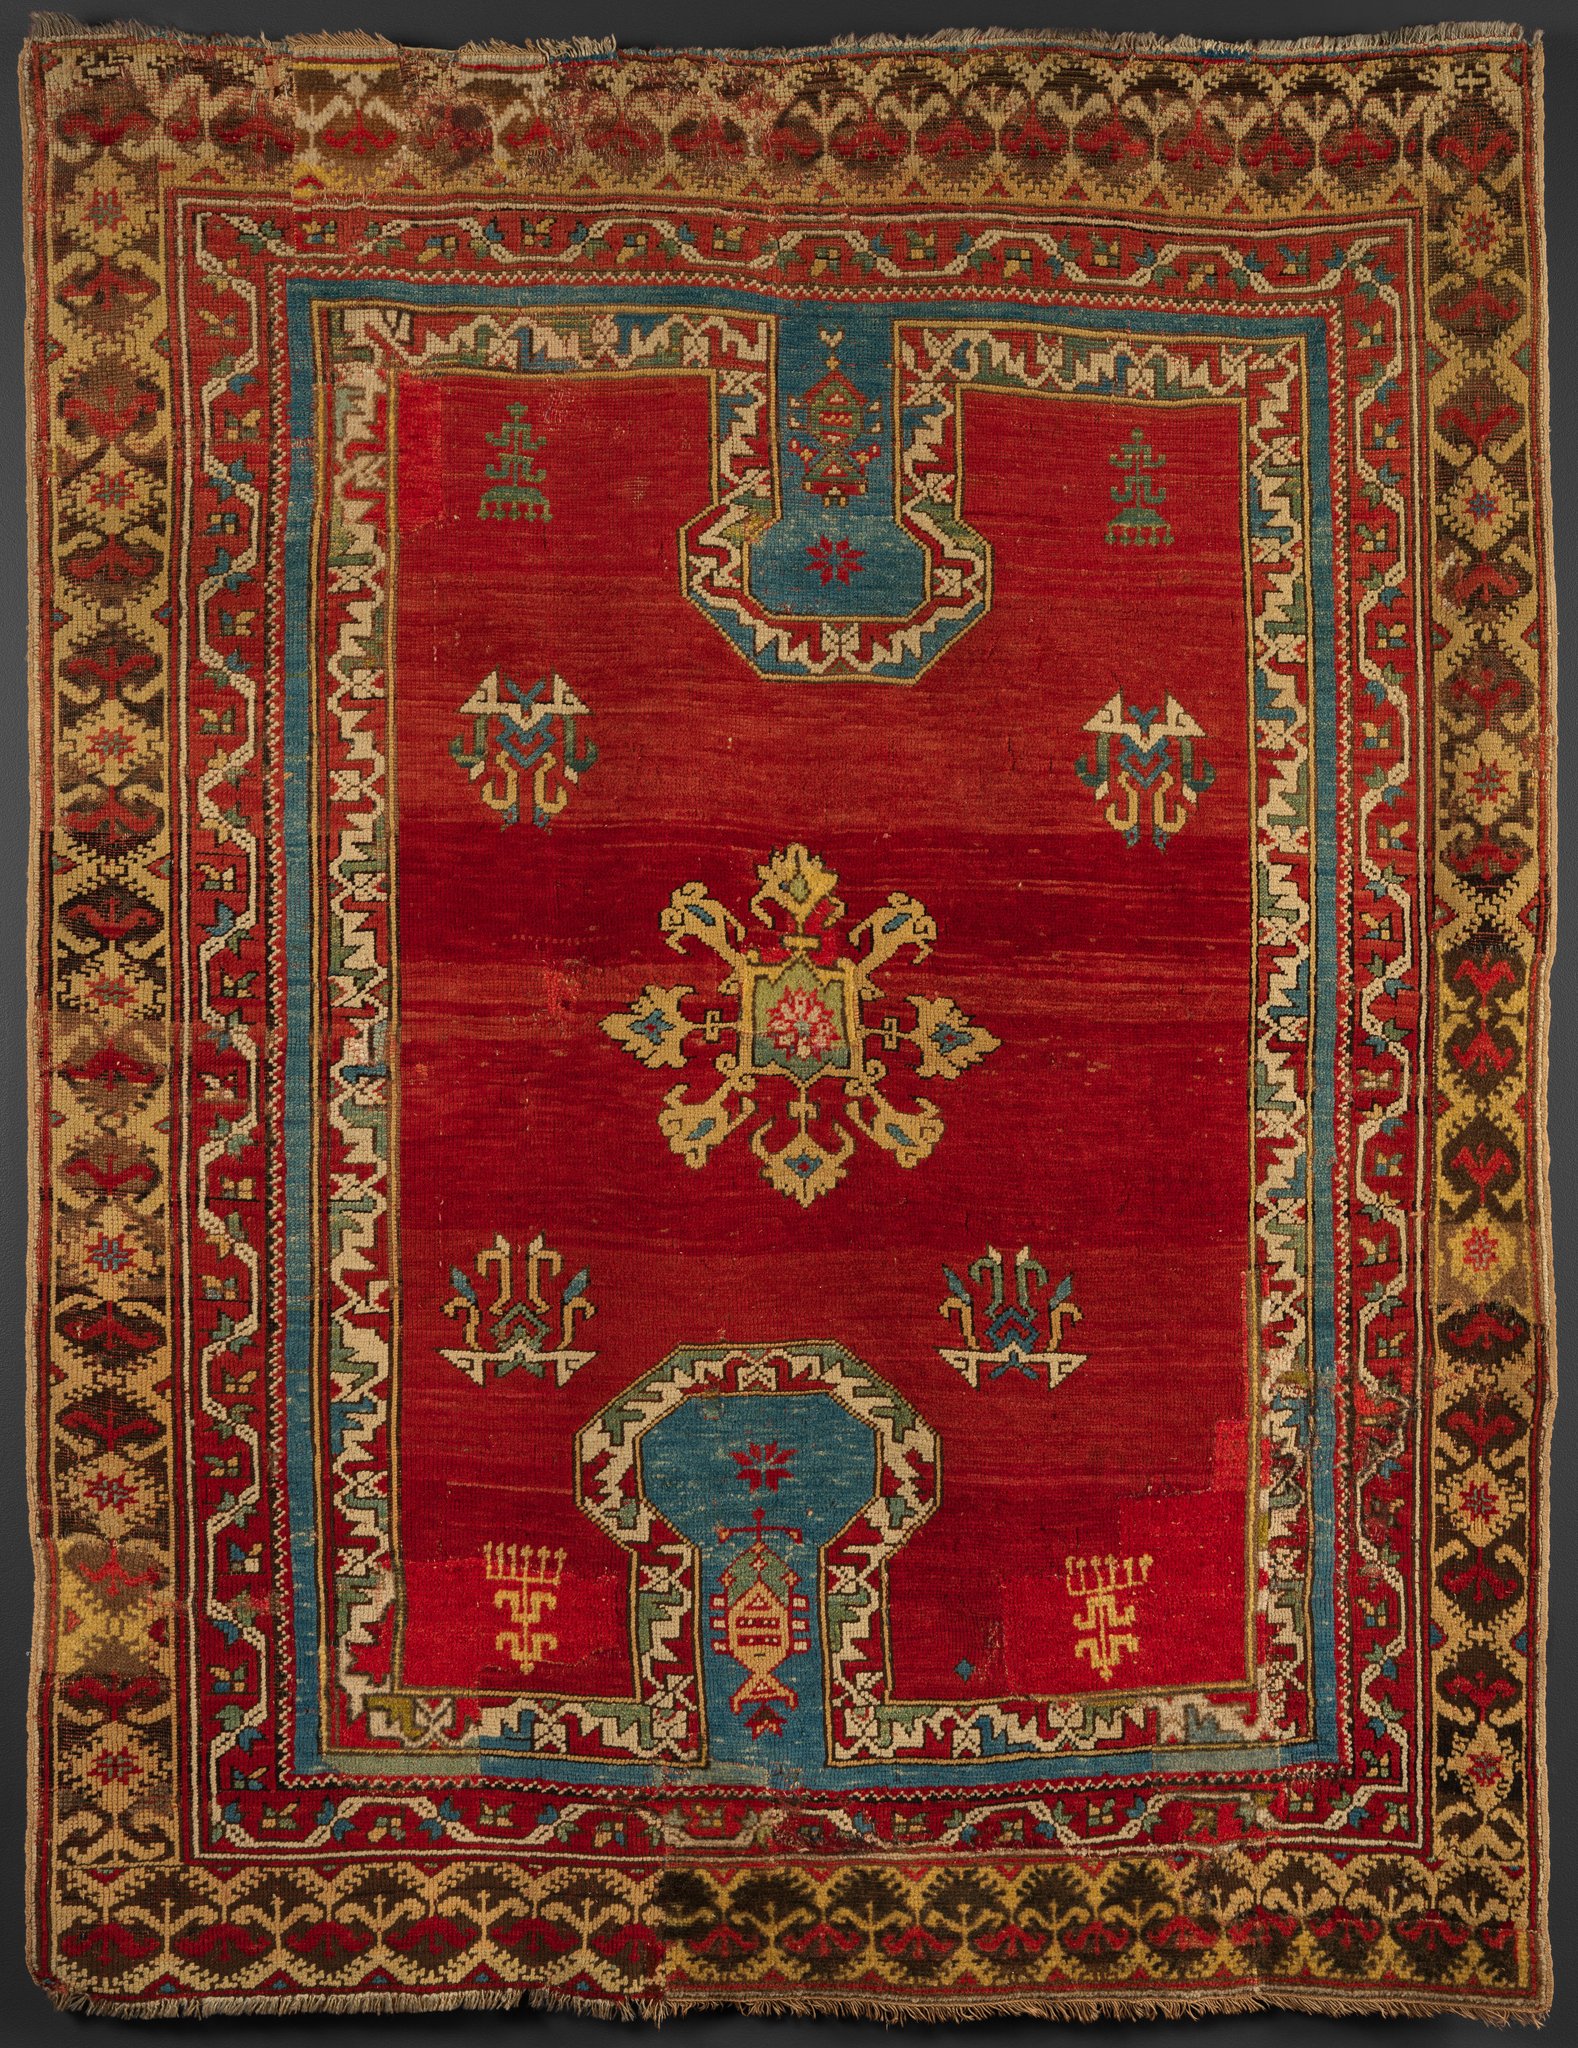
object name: carpet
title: "Bellini" Carpet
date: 1601-1700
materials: wool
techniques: pile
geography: turkey